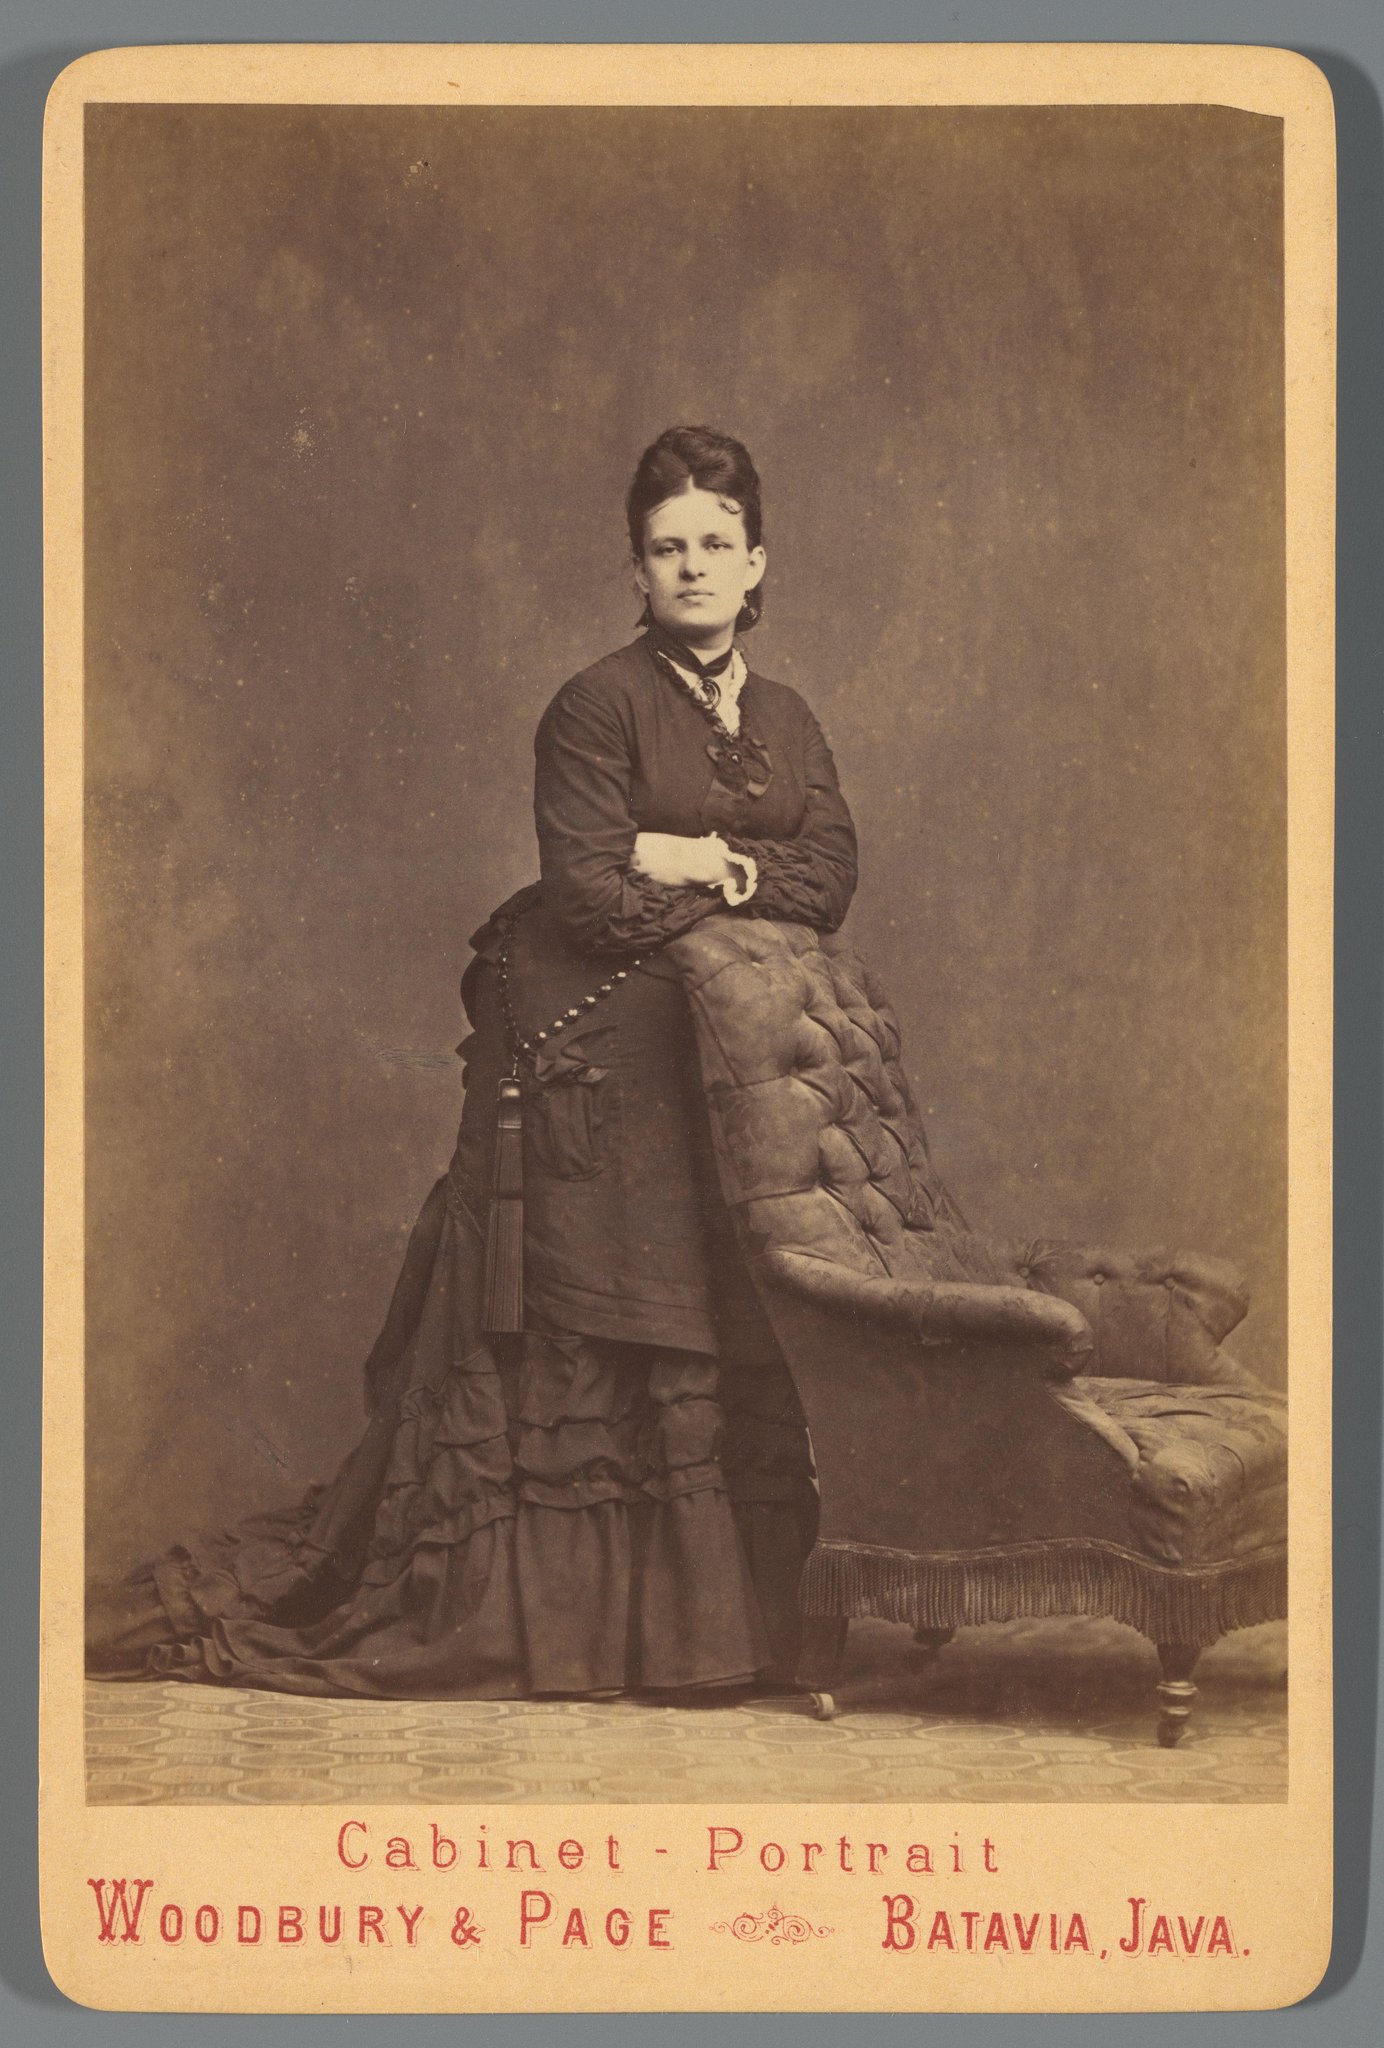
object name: cabinet photograph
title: Portret van Françoise van den Berg-Schas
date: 1870-1900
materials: cardboard, photographic support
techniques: albumen print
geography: batavia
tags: francina schas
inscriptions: name: ‘Françoise vandenBerg / Schas’, name: ‘WOODBURY & PAGE / Photographers / JAVA.’, name: ‘Cabinet - Portrait / WOODBURY & PAGE BATAVIA, JAVA.’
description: Studioportret van staande vrouw leunend op de rugleuning van een fauteuil.